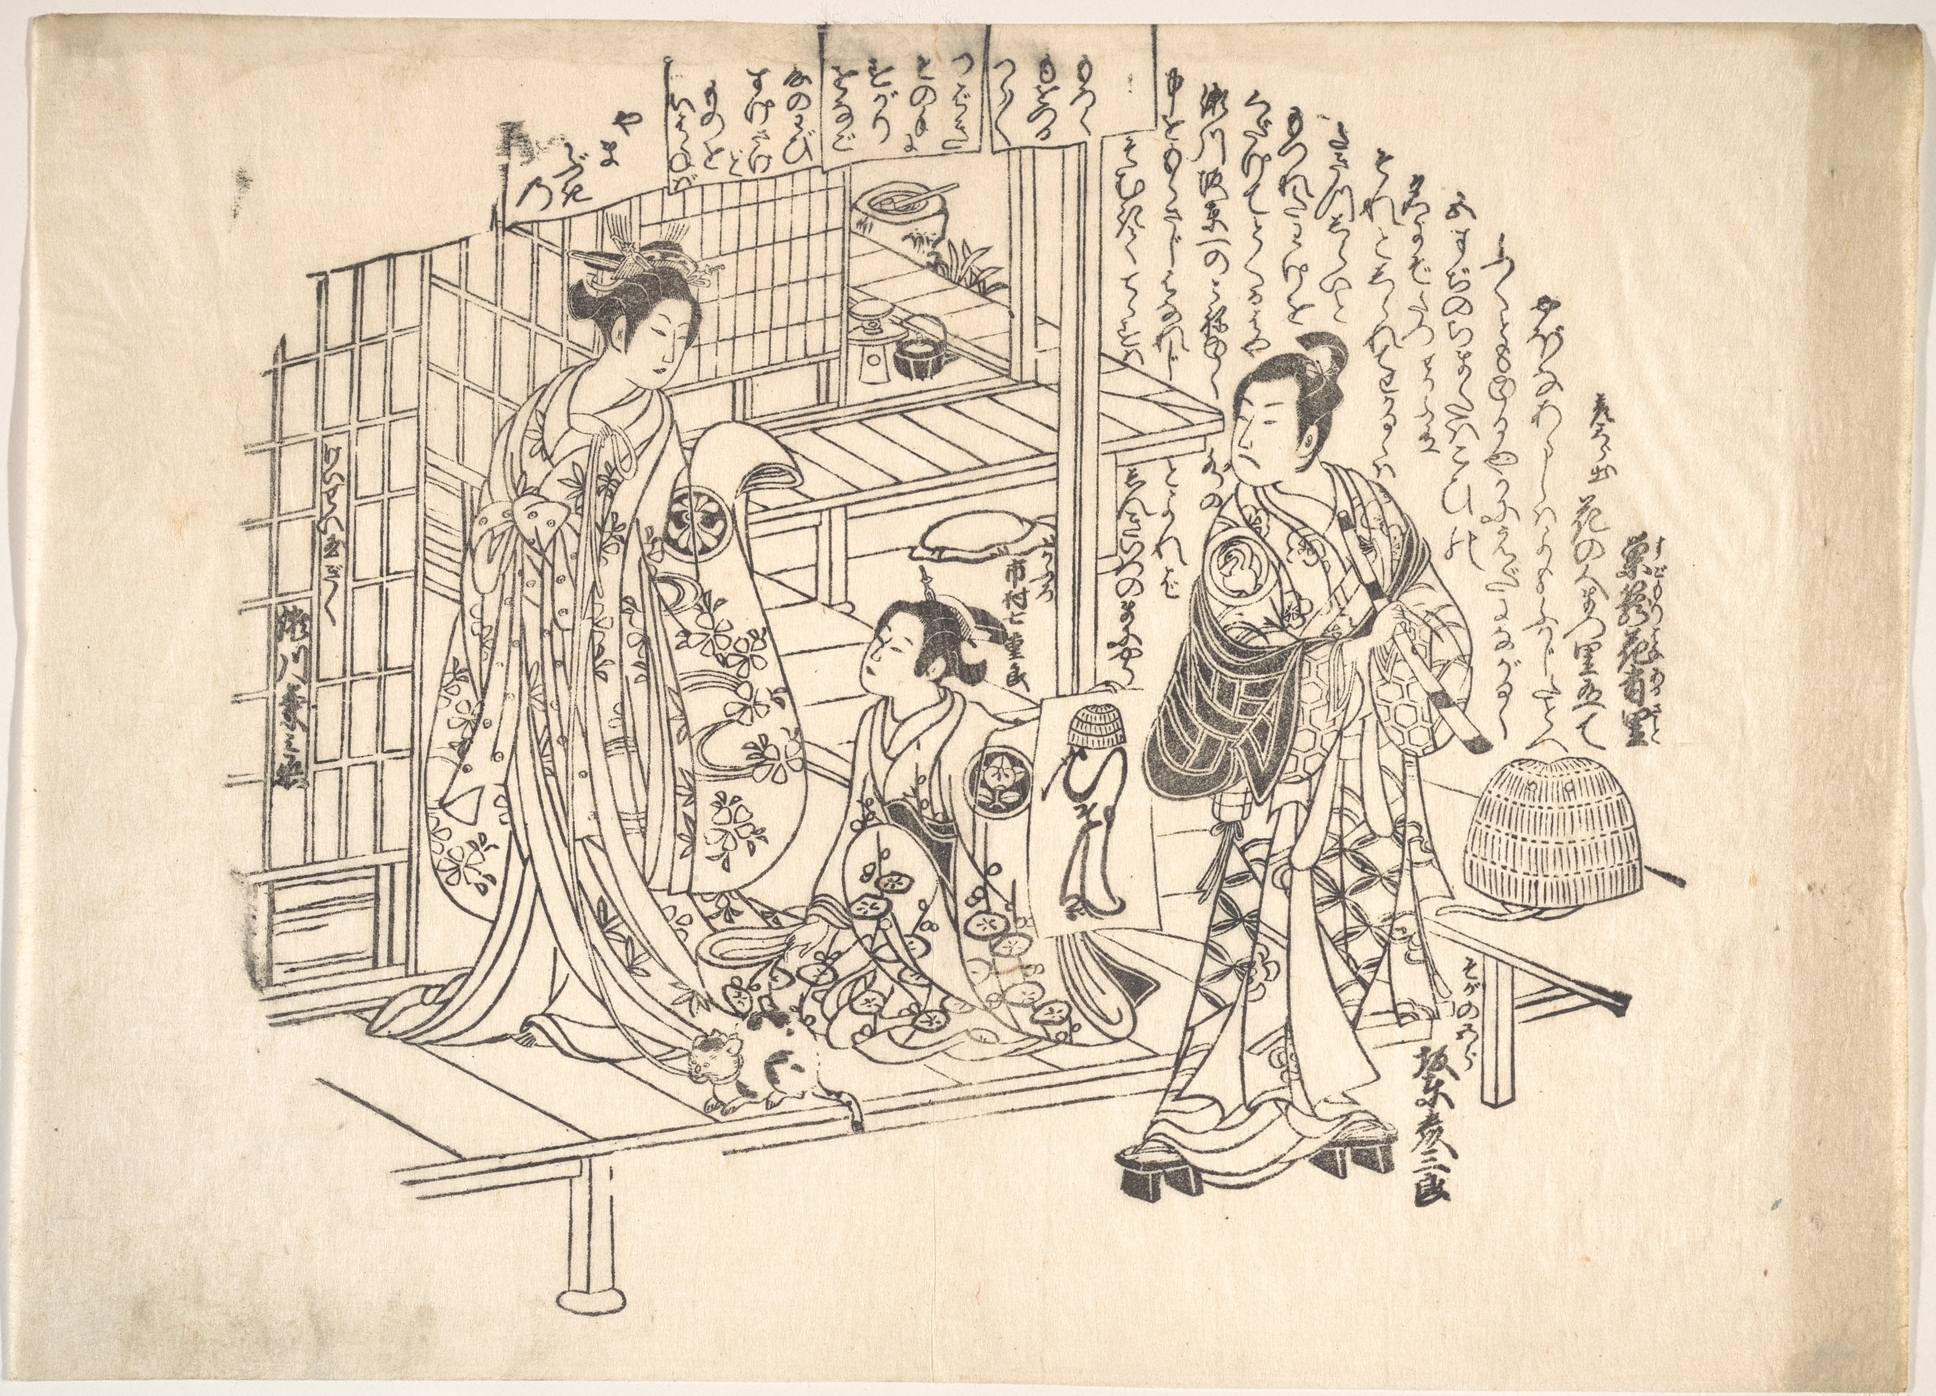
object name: print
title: One of Six Impressions from Worn Old Blocks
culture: japanese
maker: unidentified artist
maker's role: artist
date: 1700-1799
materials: ink, paper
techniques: woodblock print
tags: men,women